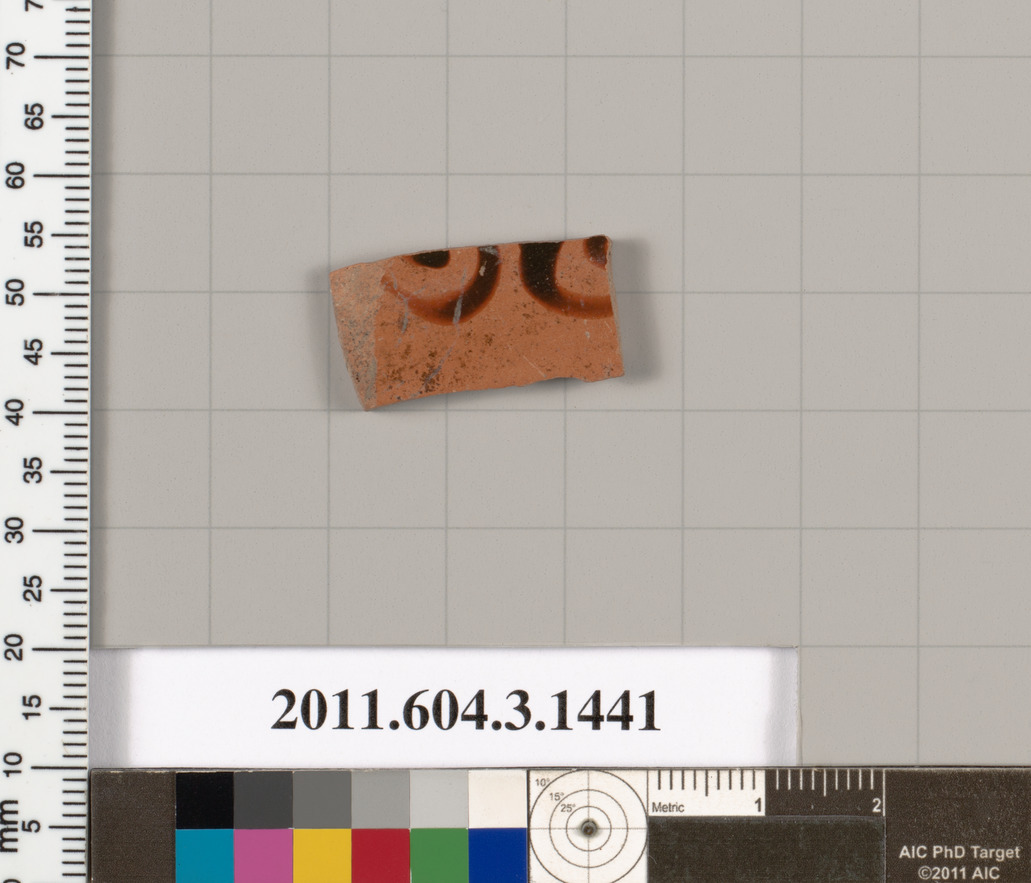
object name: skyphos fragment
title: Terracotta fragment of a skyphos (deep drinking cup)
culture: greek, attic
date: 500-468 BCE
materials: terracotta